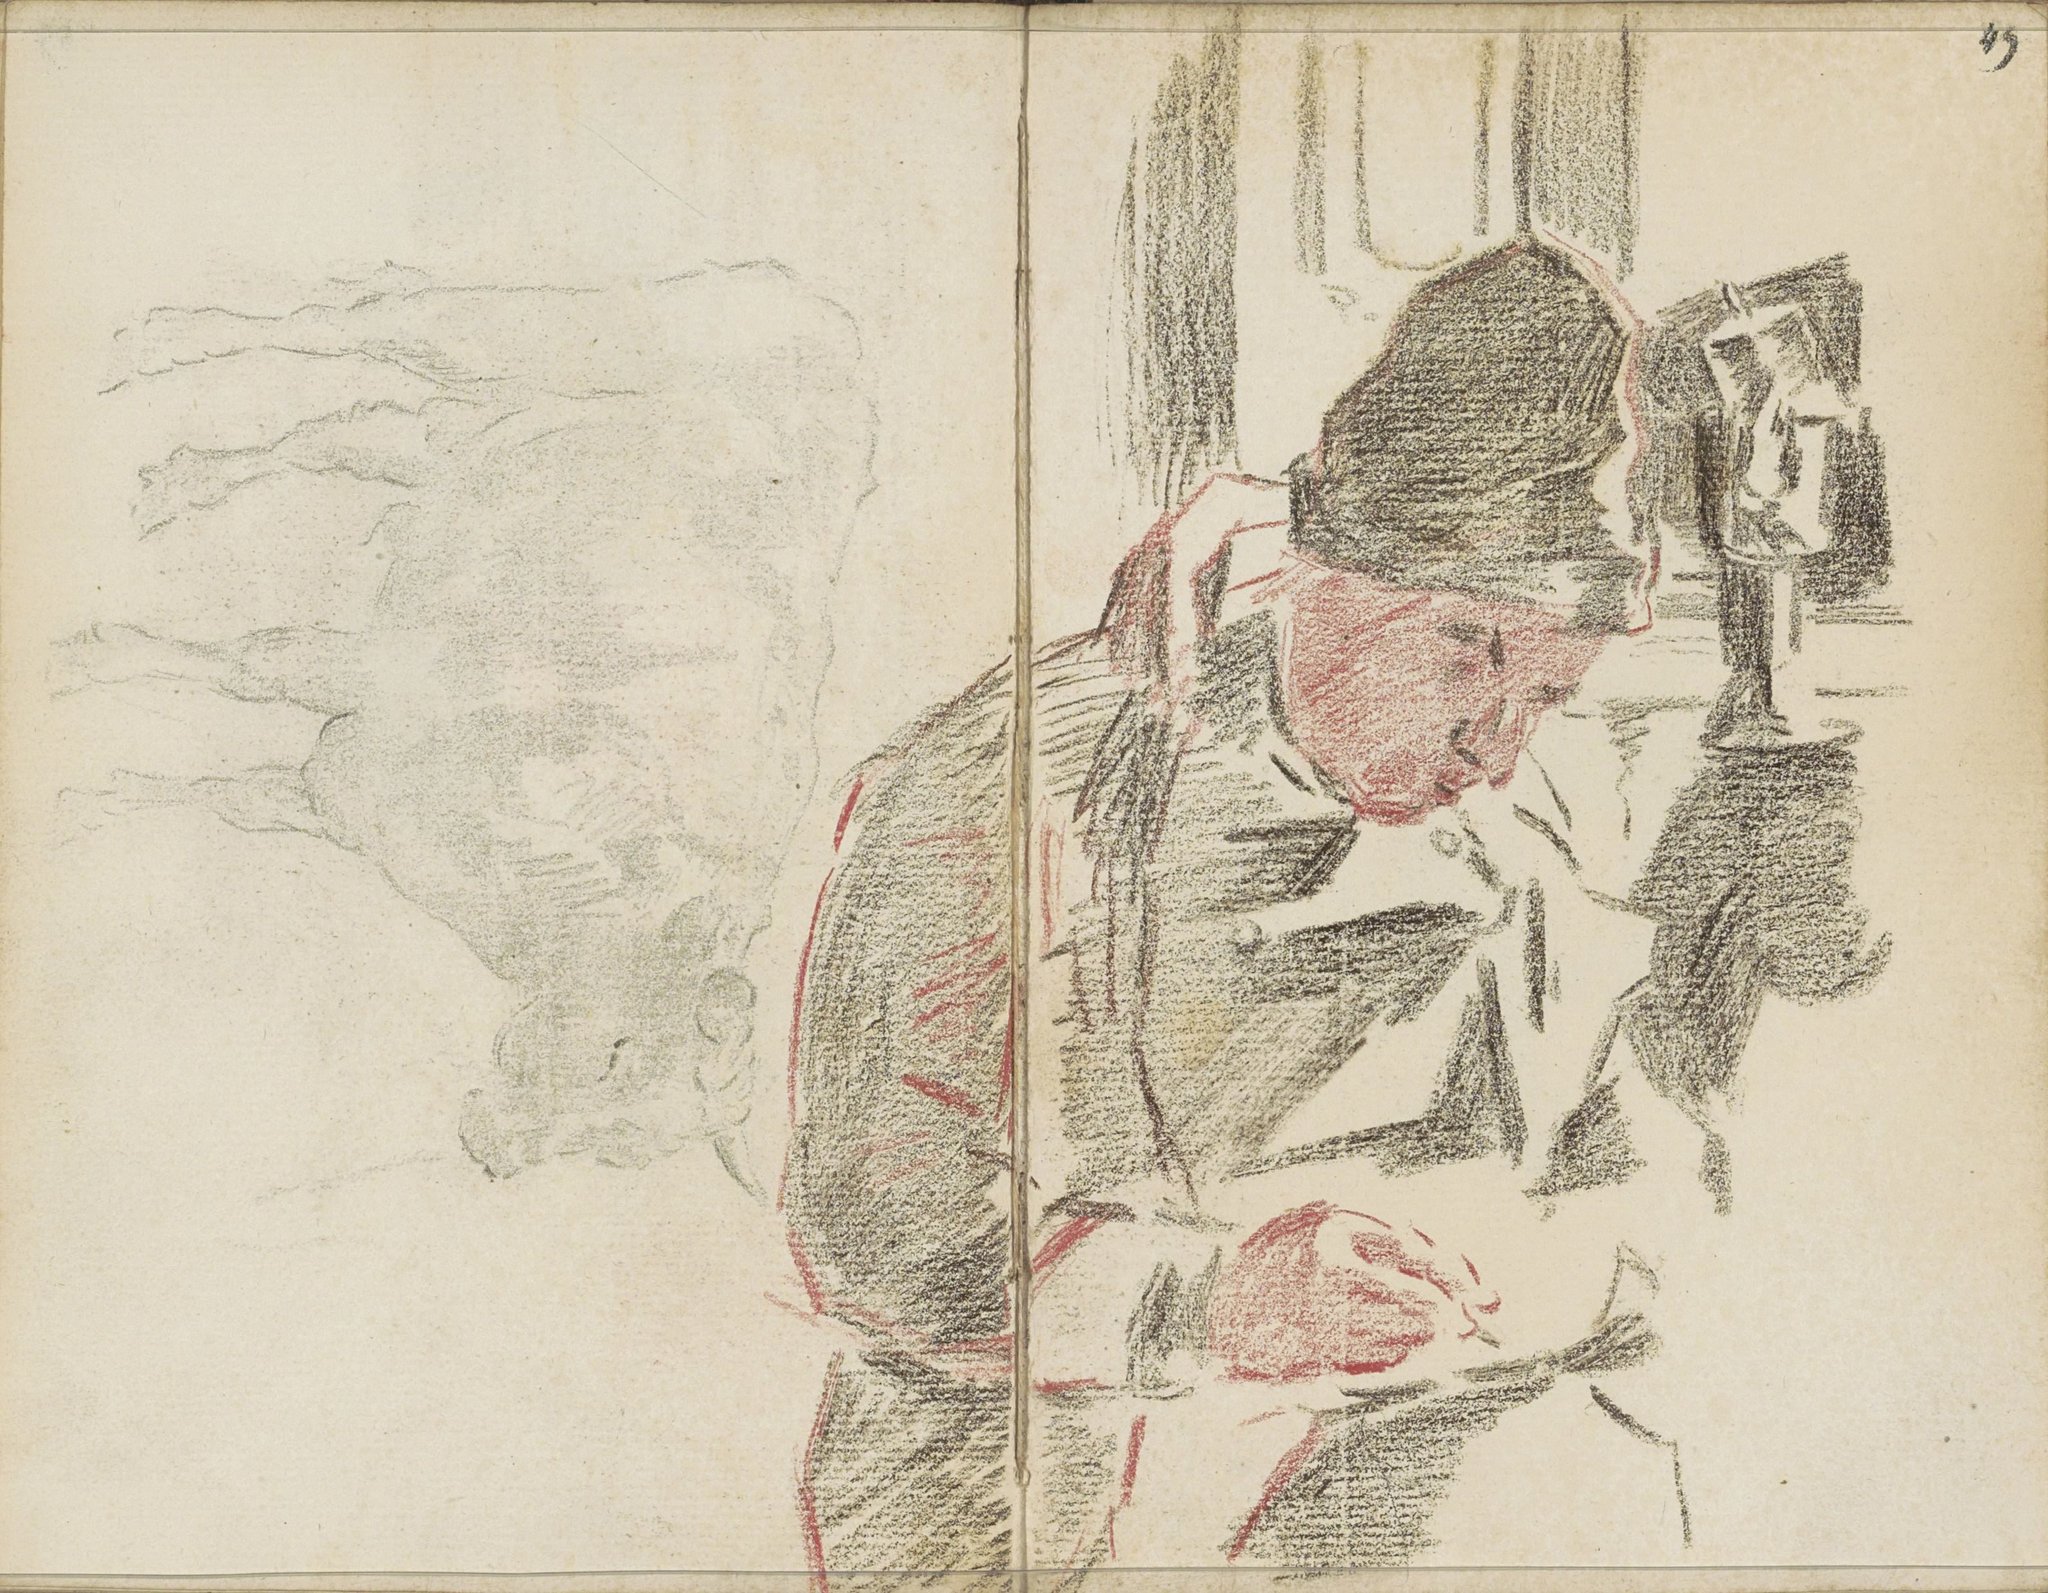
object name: sketchbook leaf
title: Koe en een schrijvende man bij een kaars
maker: jacob perkois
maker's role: draughtsman, print maker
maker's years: 1756-1804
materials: chalk, paper, pencil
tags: cow, writing and letters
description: Bladzijden 48 en 49 uit een schetsboek met 78 bladzijden.